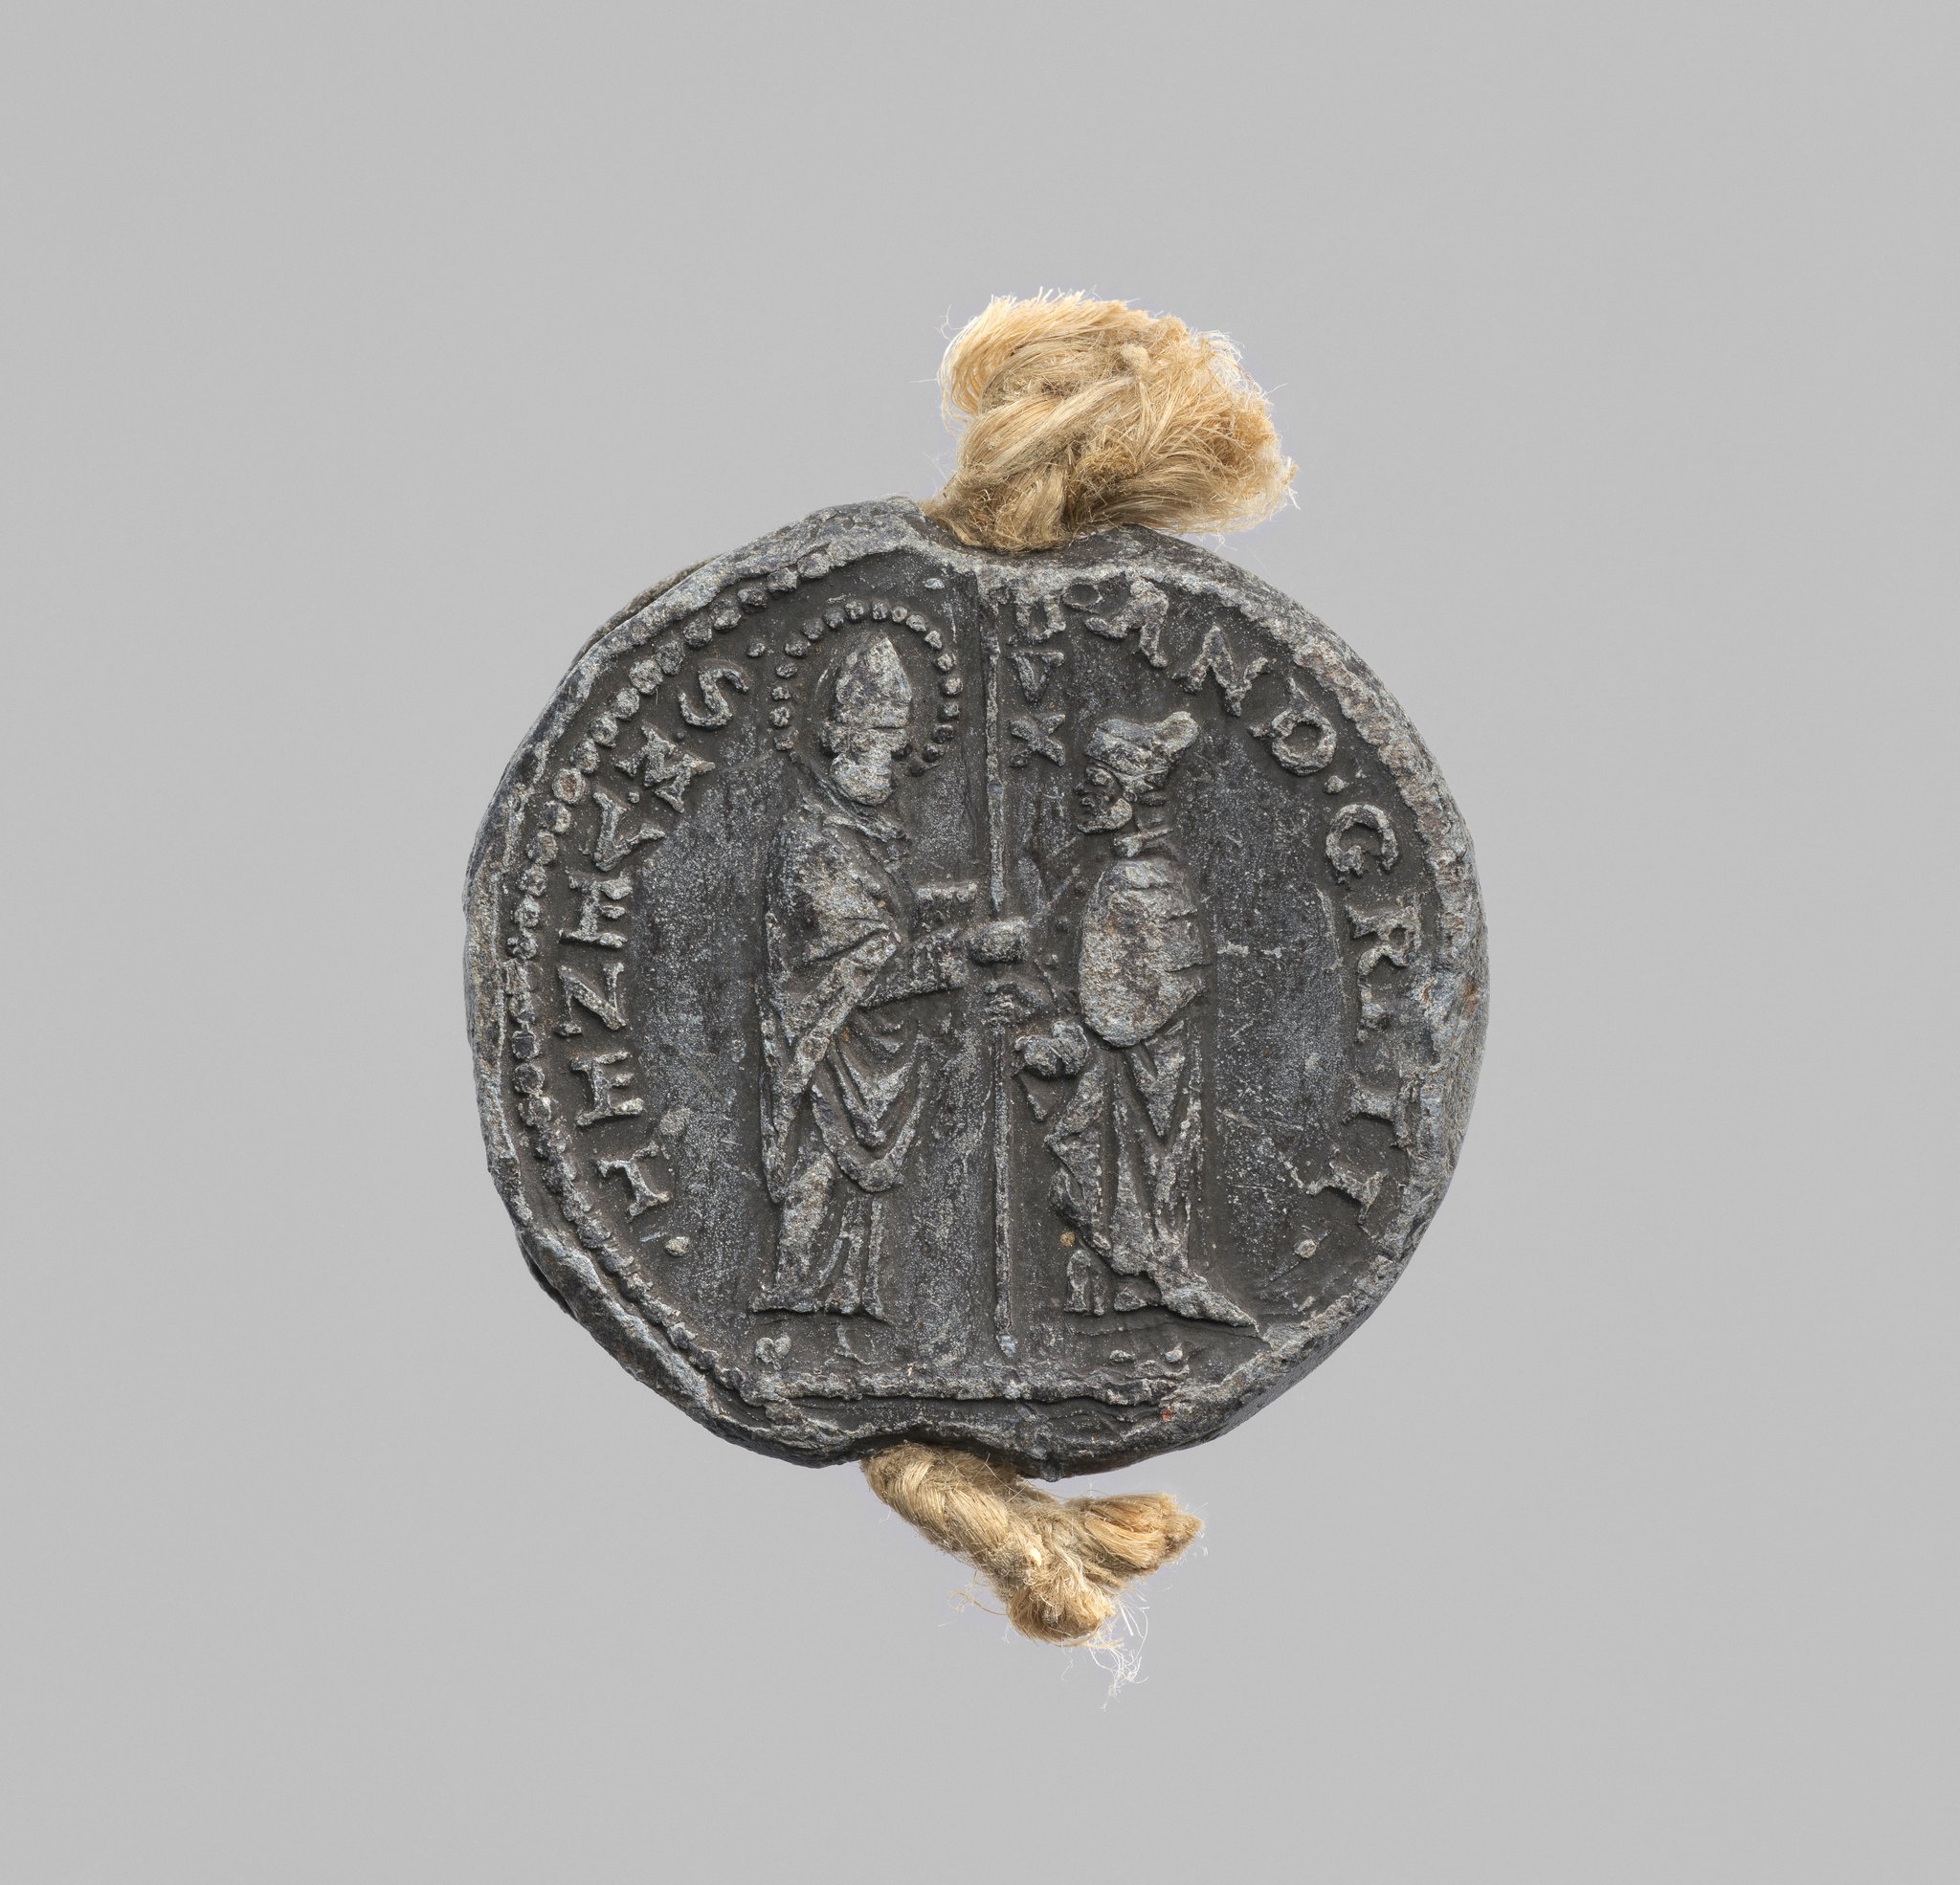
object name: seal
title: Andrea Gritti (r. 1523–38)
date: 1523-1538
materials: cord, lead